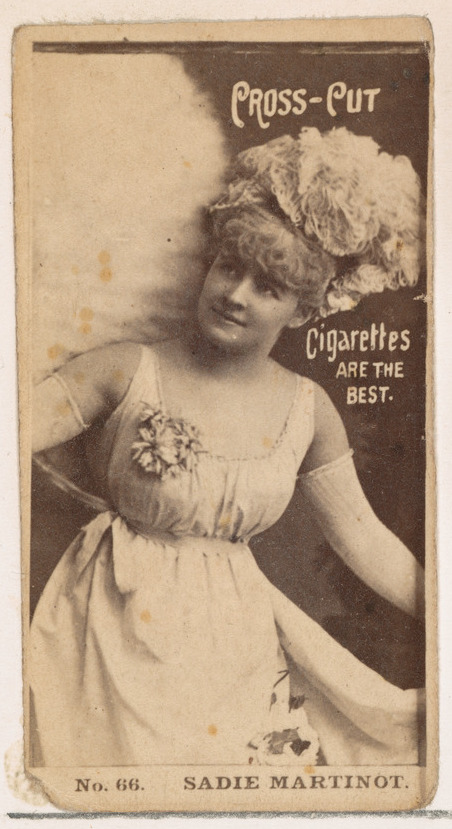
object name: print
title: Card Number 66, Miss Sadie Martinot, from the Actors and Actresses series (N145-2) issued by Duke Sons & Co. to promote Cross Cut Cigarettes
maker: w. duke, sons & co.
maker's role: publisher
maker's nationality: american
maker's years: 1870-1920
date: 1880-1889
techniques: albumen silver print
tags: portraits,women,actresses